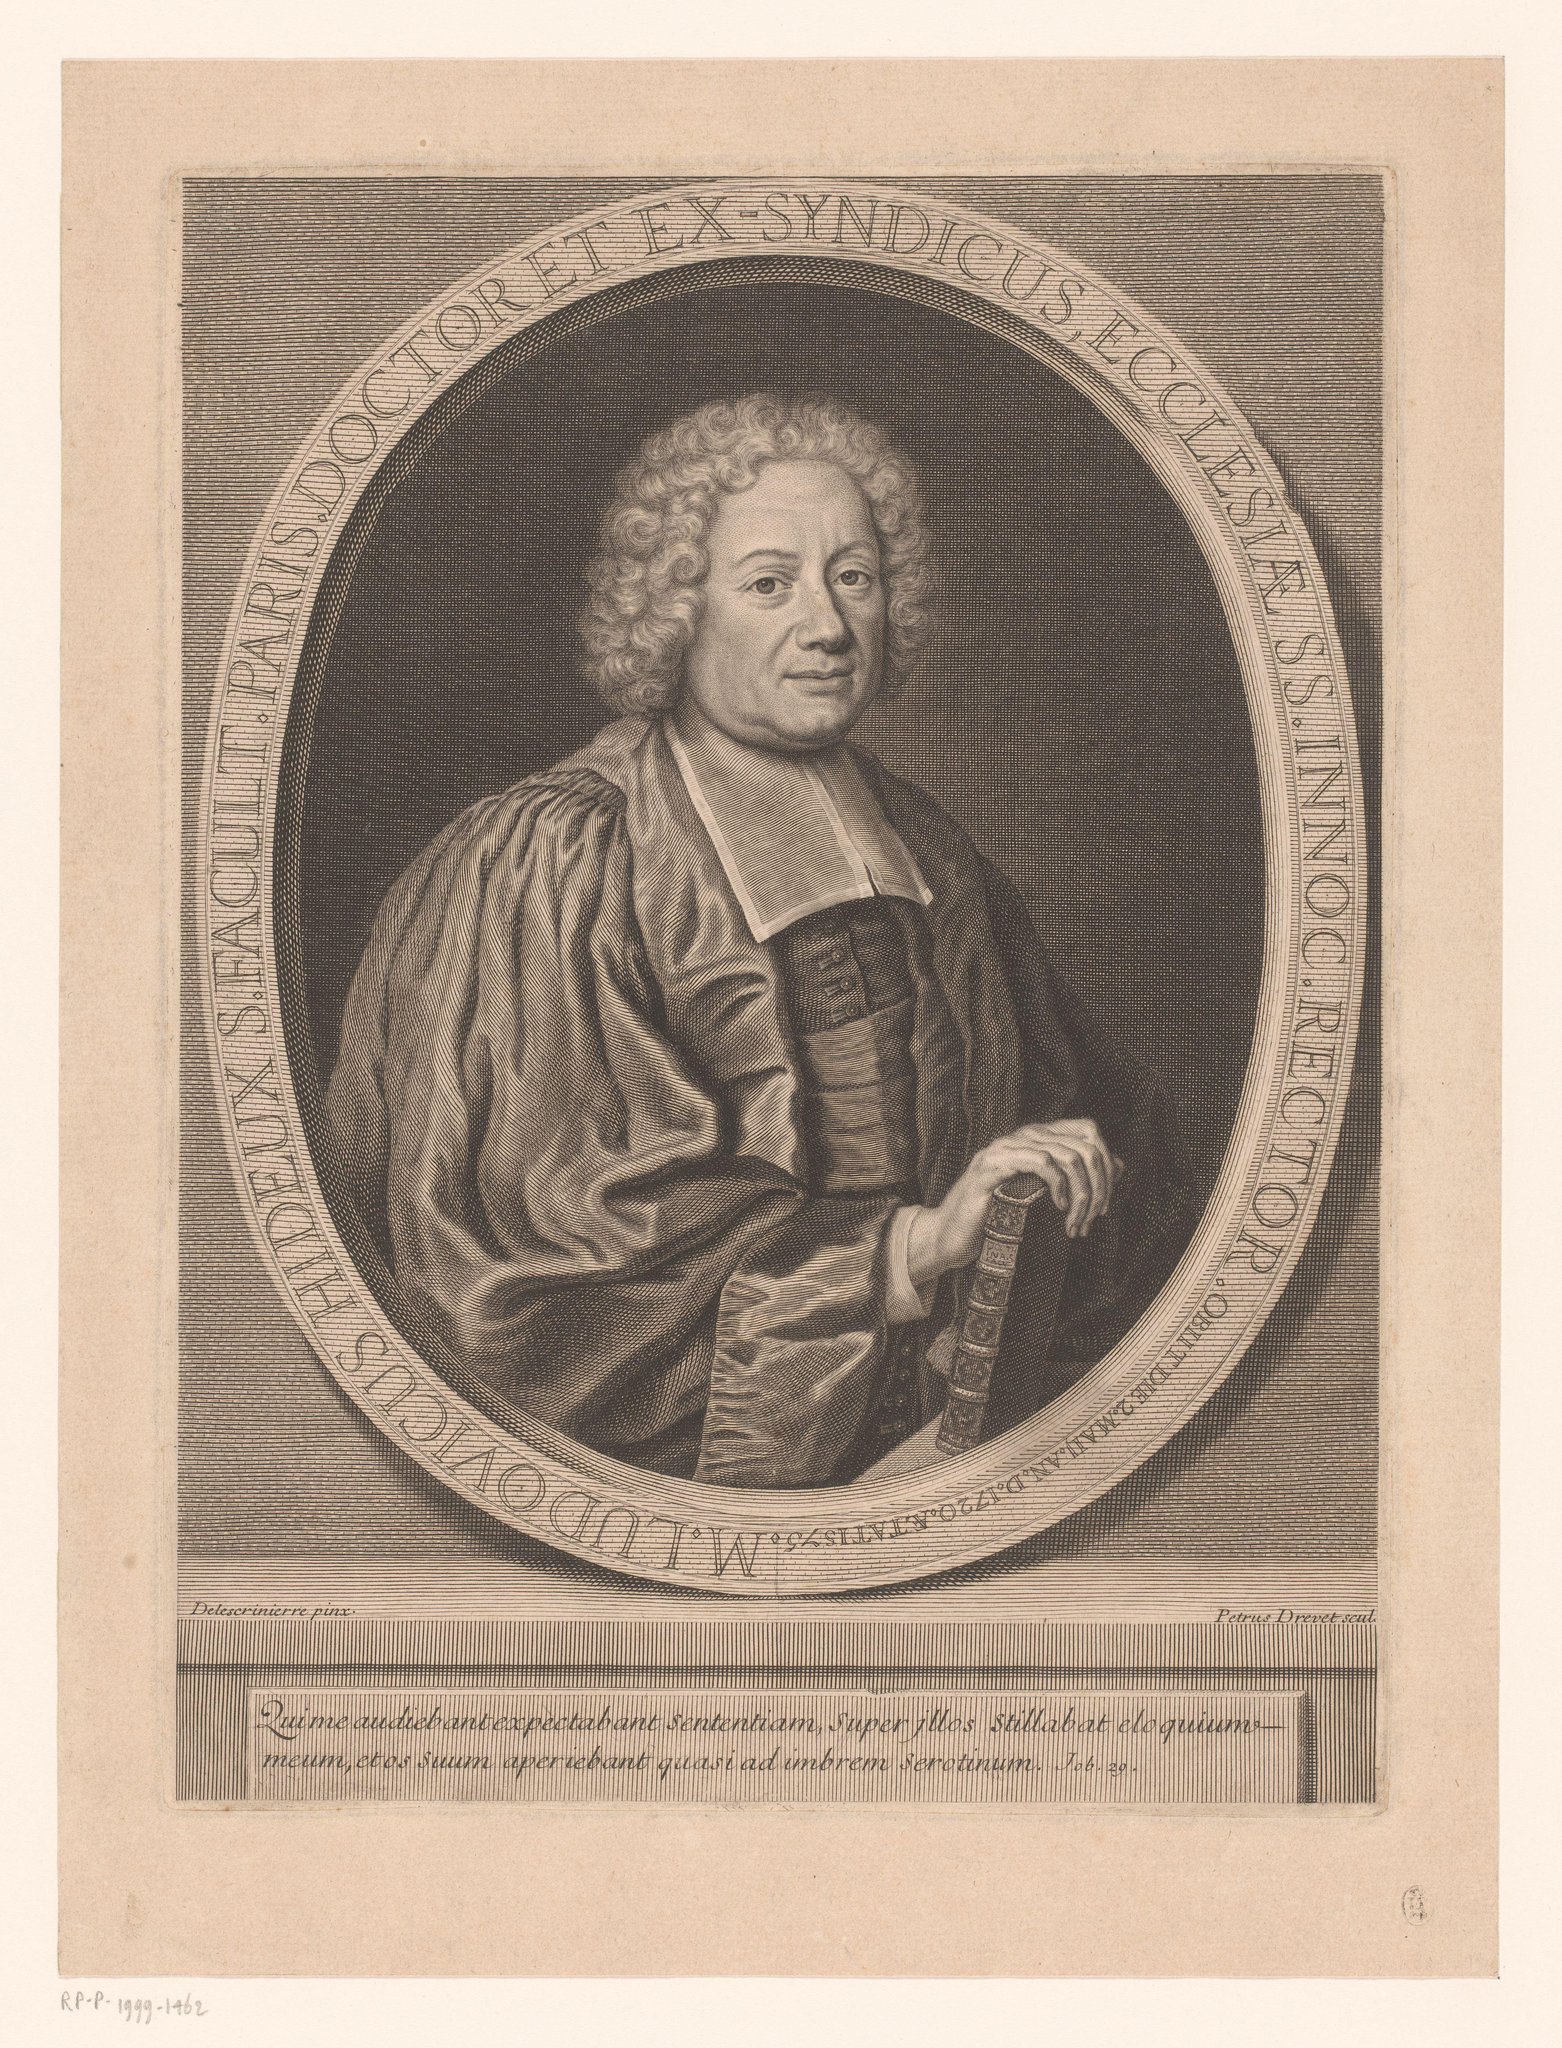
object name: print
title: Portret van Louis Hideux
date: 1720-1738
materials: paper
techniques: engraving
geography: france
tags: clergyman, ornament ~ medallion, historical persons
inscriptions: collector's mark: Lugt 2228, collector's mark: ‘[...]’, collector's mark: Lugt 2760